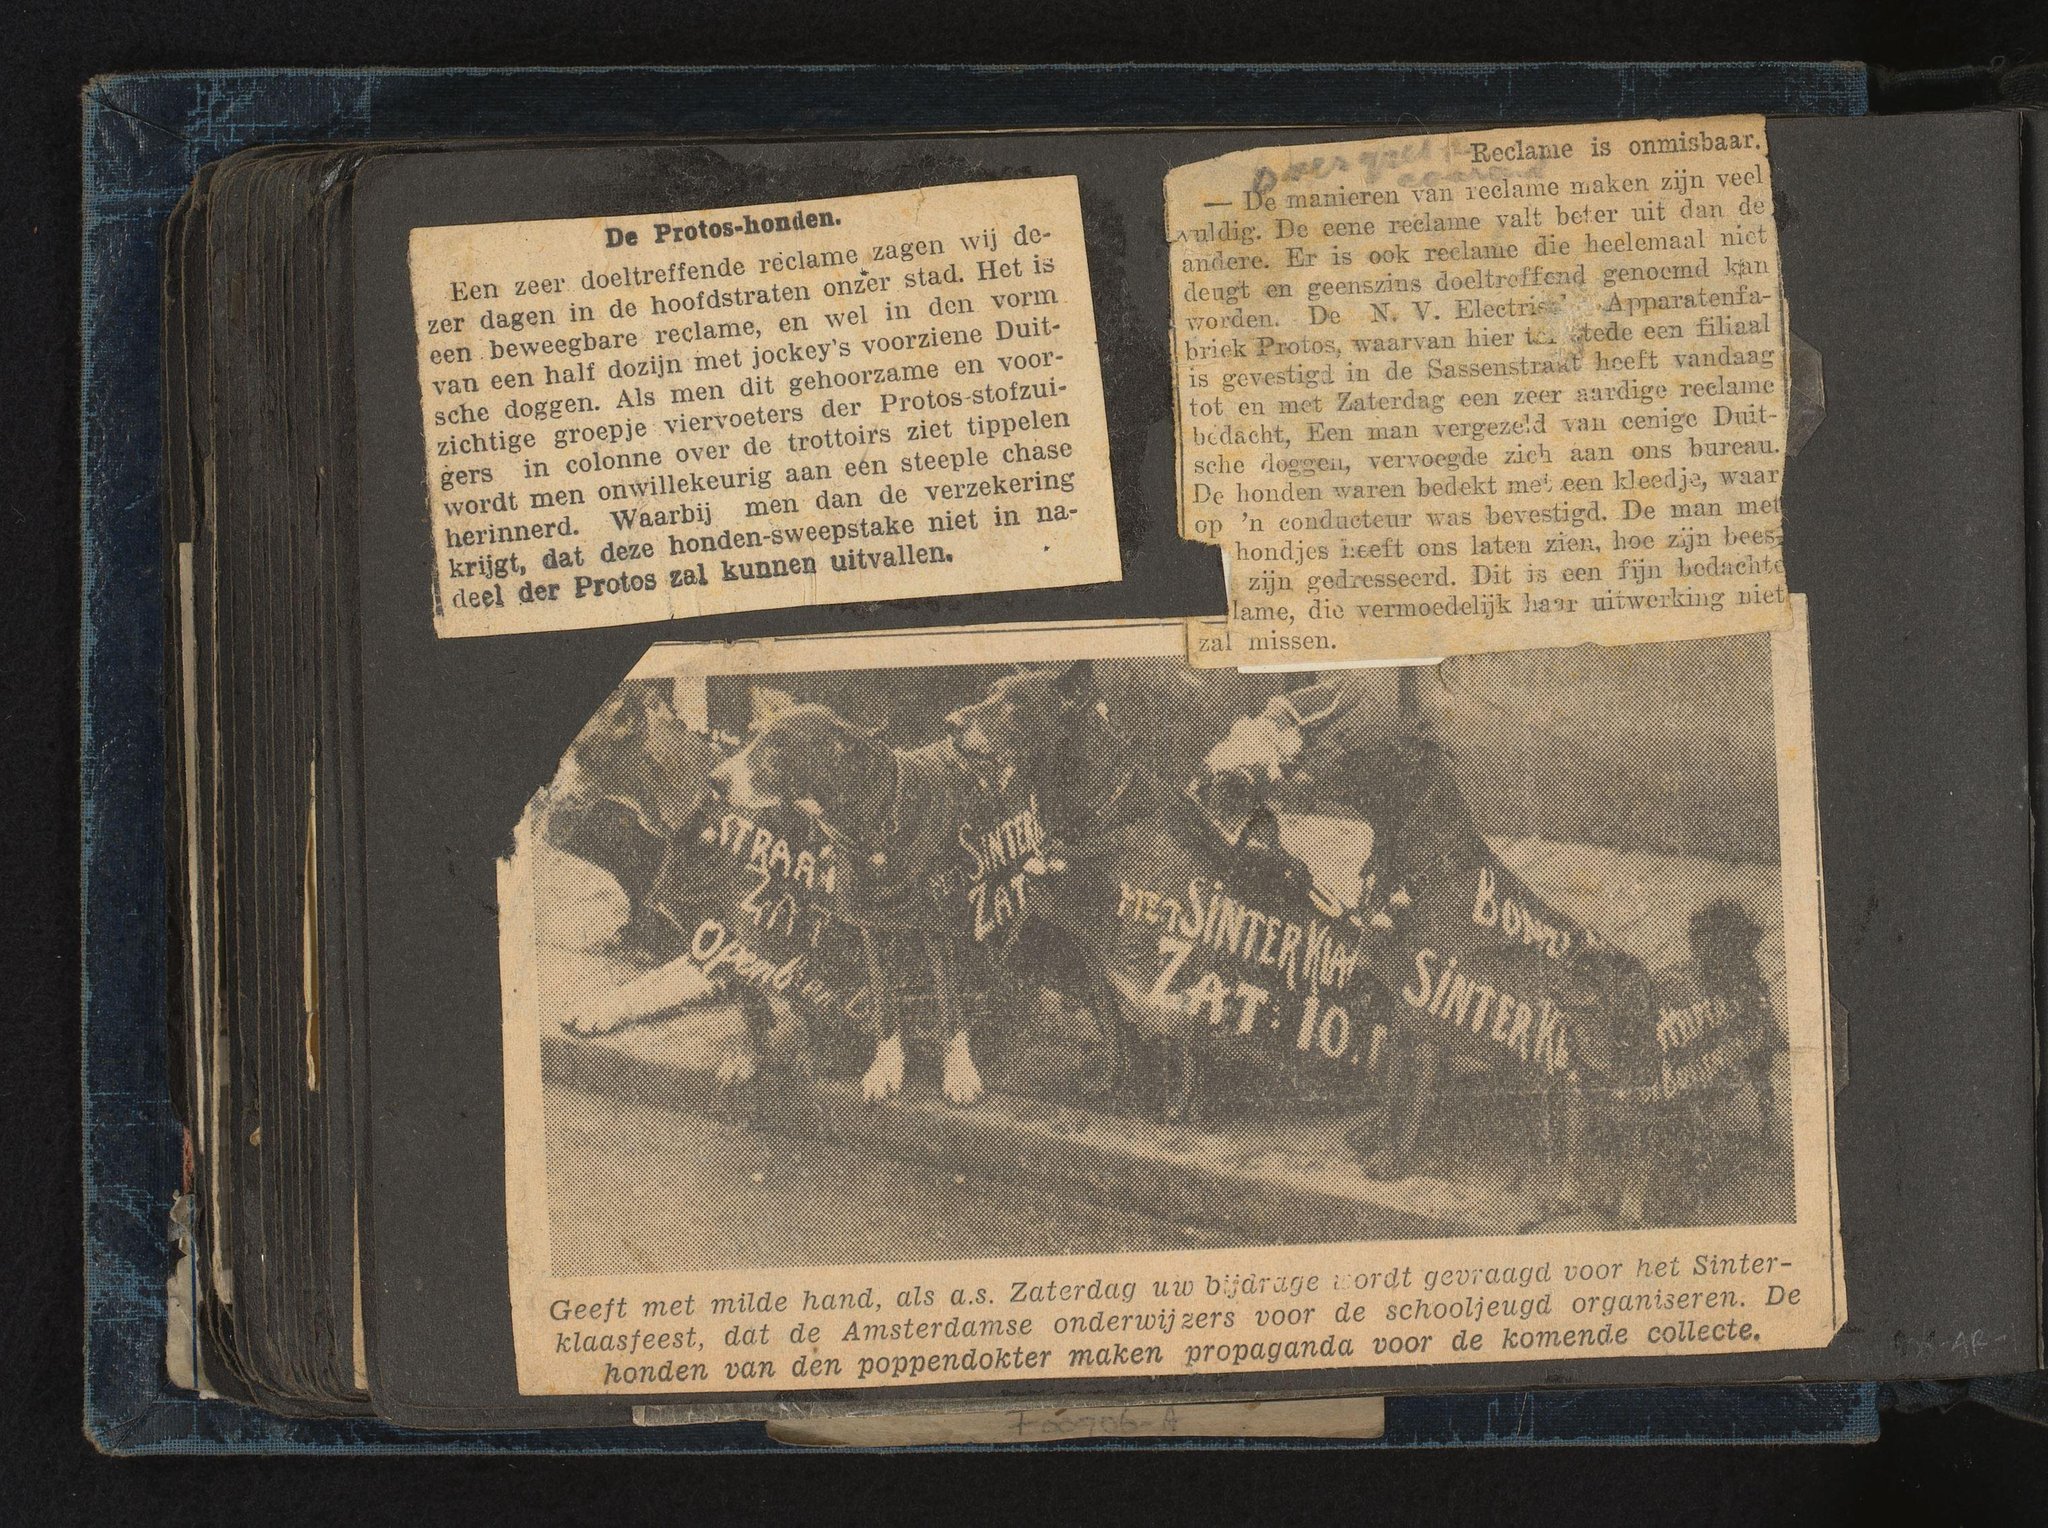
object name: newspaper clipping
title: Reclamehonden van de Poppendokter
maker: Anonymous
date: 1930-1940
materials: paper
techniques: autotype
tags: advertising, dolls for adults, dog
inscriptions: inscription: ‘Geeft met milde hand, als a.s. Zaterdag uw bijdrage wordt gevraagd [...]’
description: Deze prent maakt deel uit van een album.